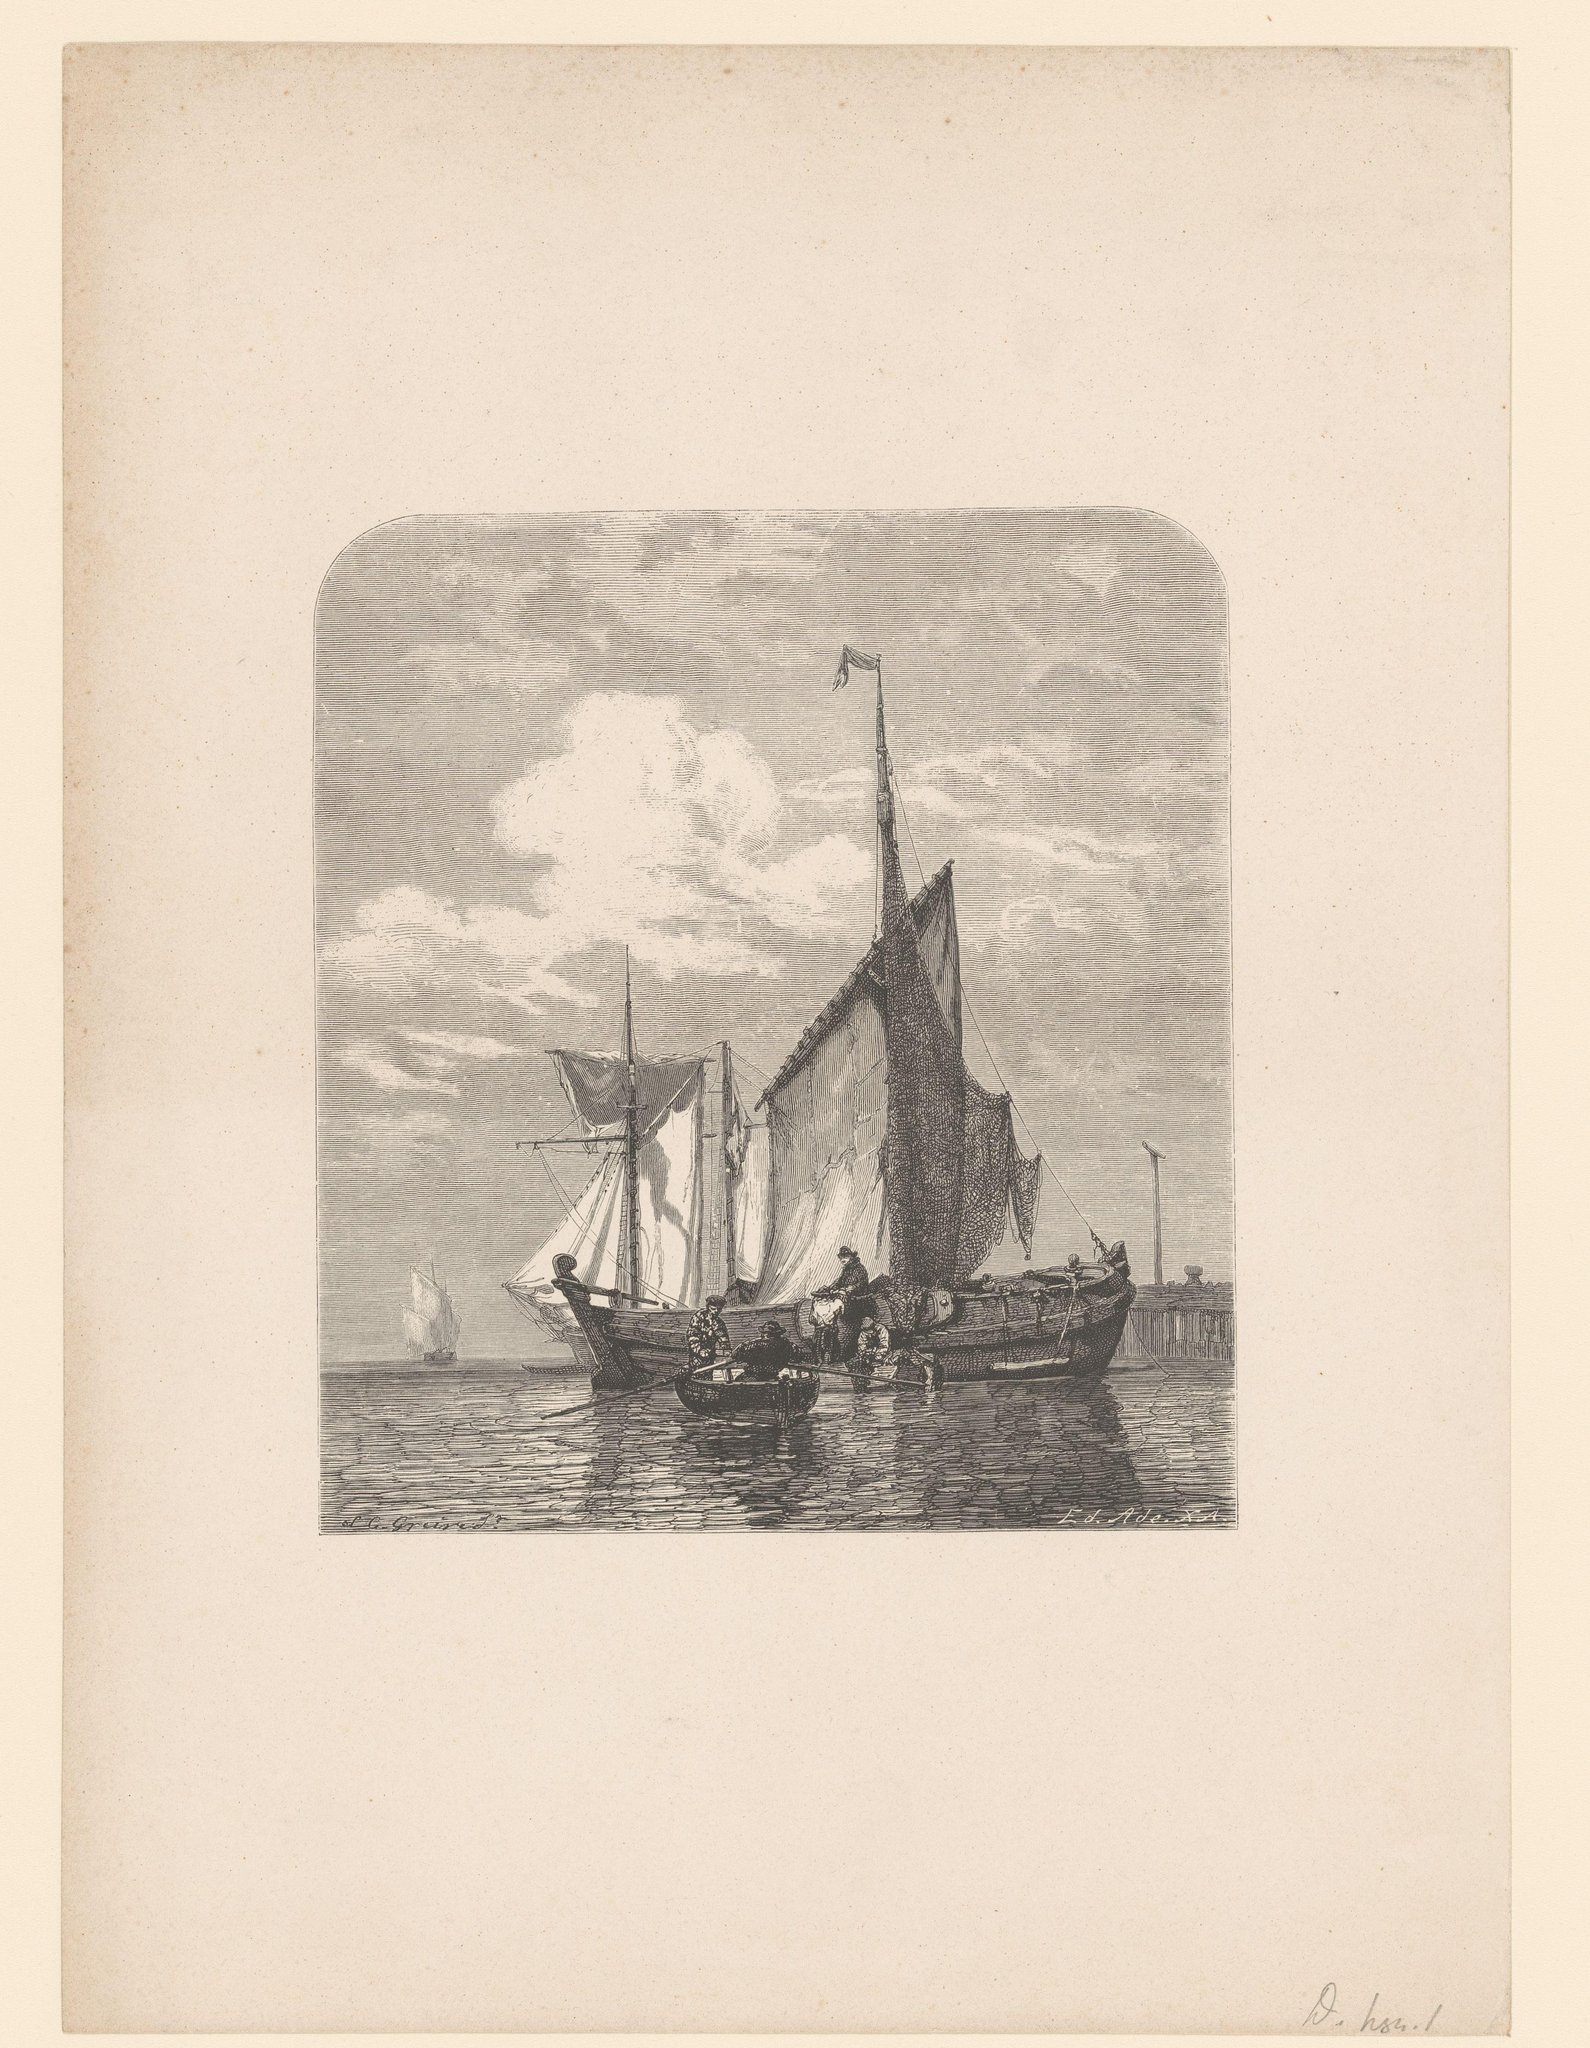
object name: print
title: Vissersboten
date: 1800-1900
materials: paper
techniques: engraving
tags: sea (seascape), ships (in general) - cc - more than one ship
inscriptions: collector's mark: Lugt 2233